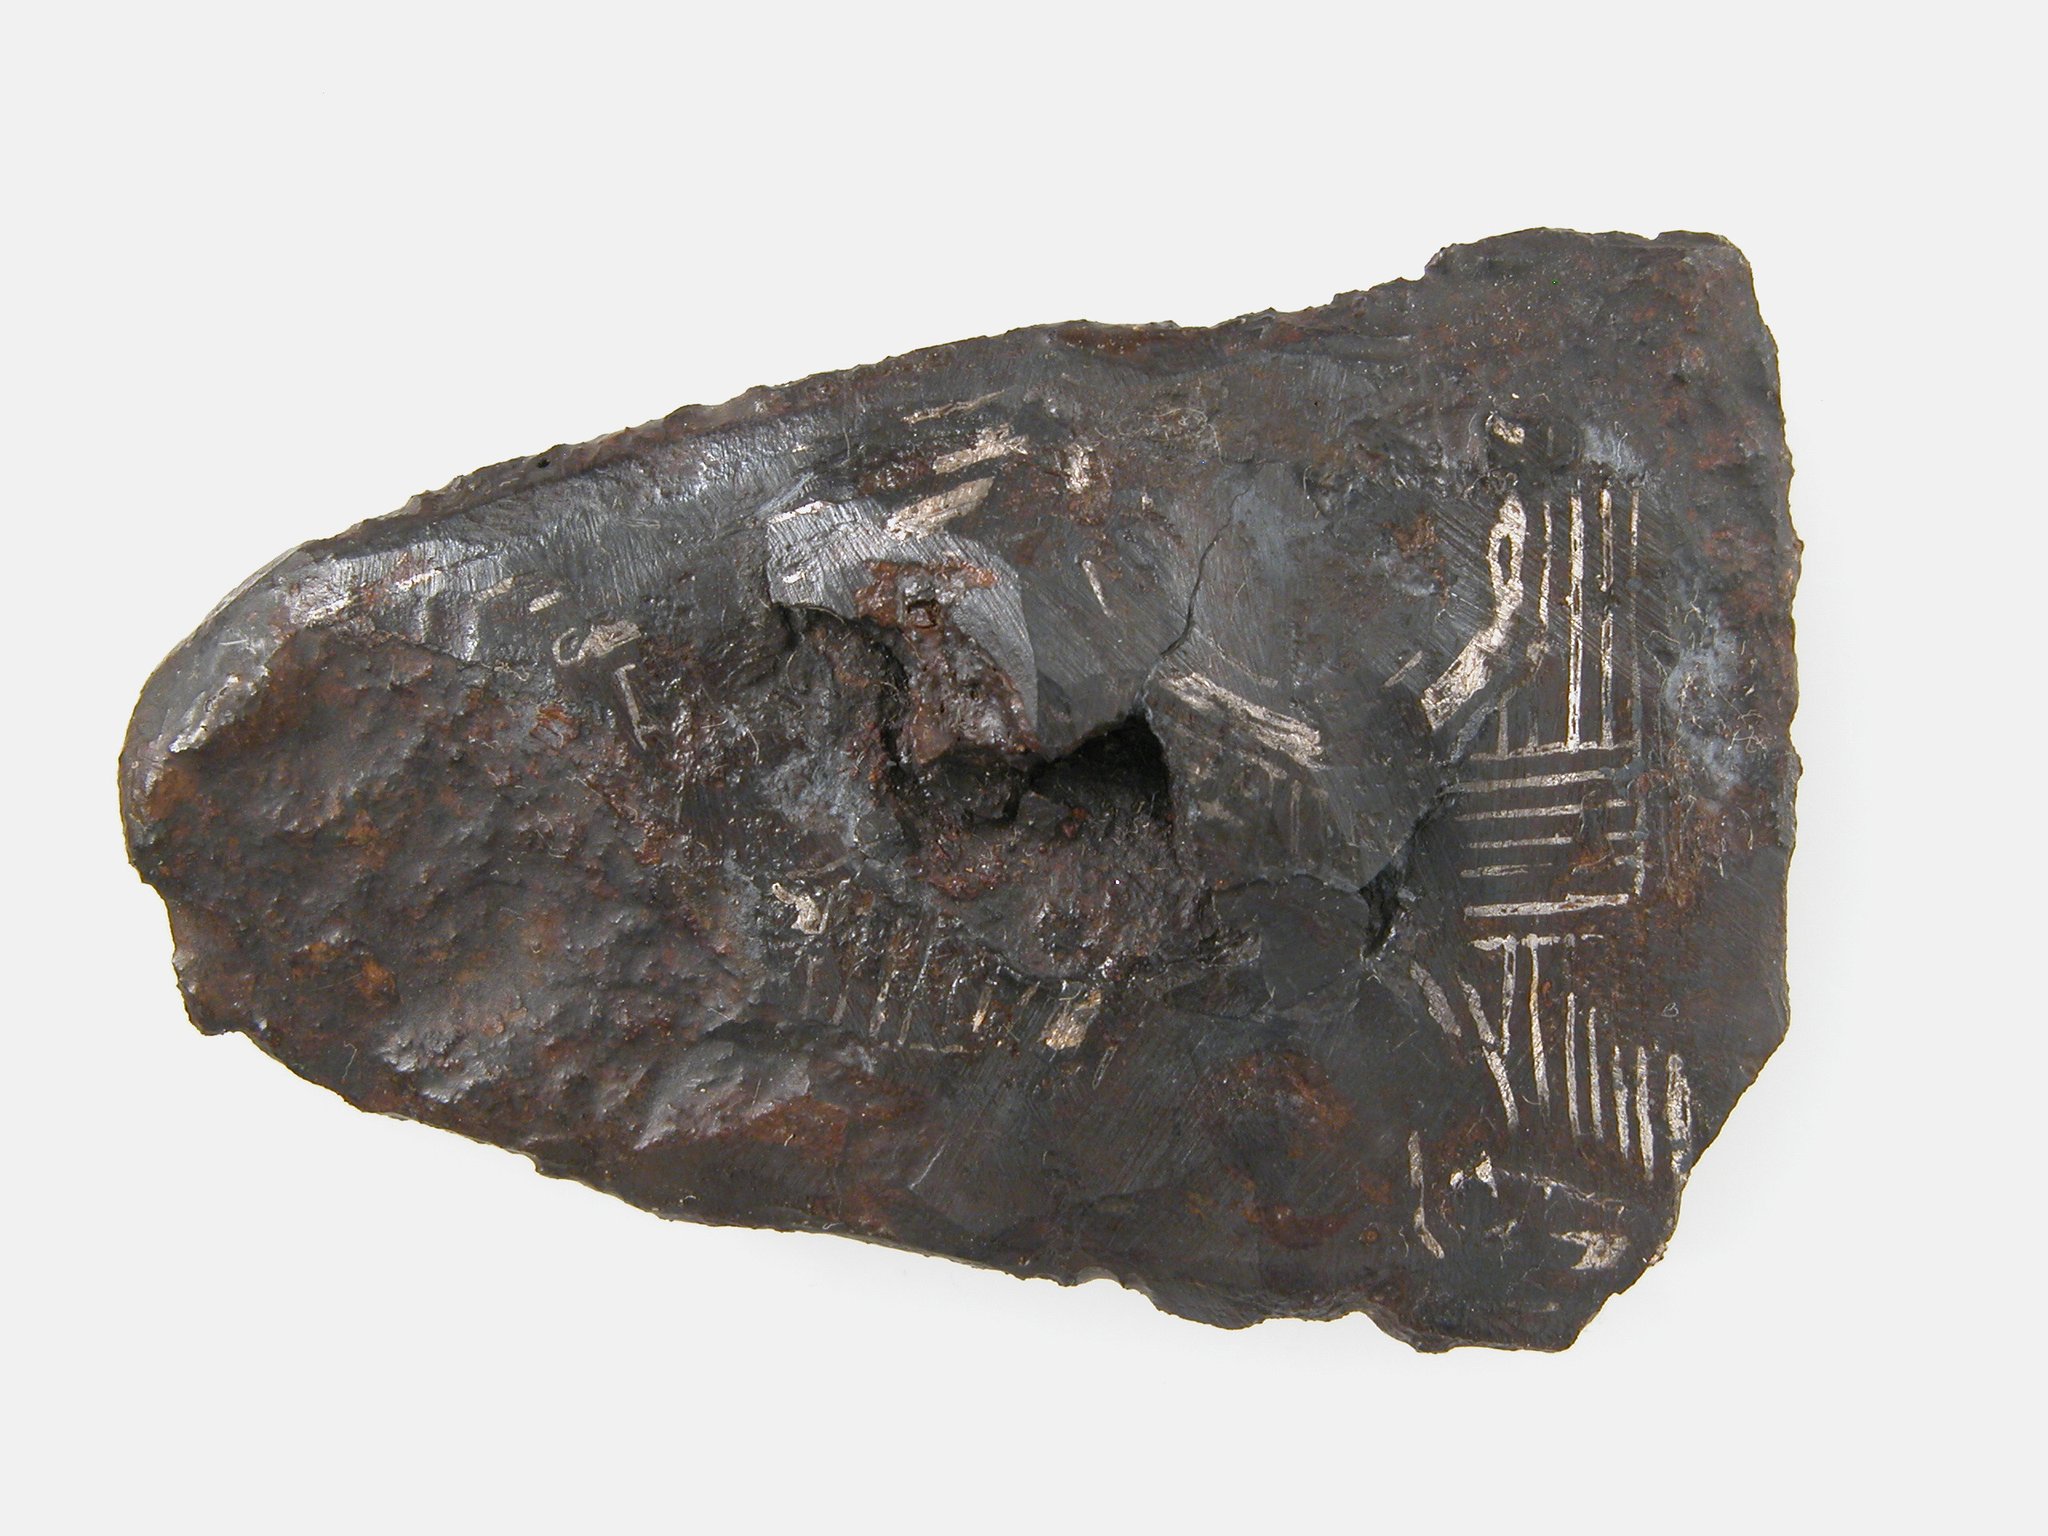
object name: buckle tongue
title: Belt Buckle Tongue Fragment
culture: frankish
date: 301-700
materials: iron, silver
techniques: inlay